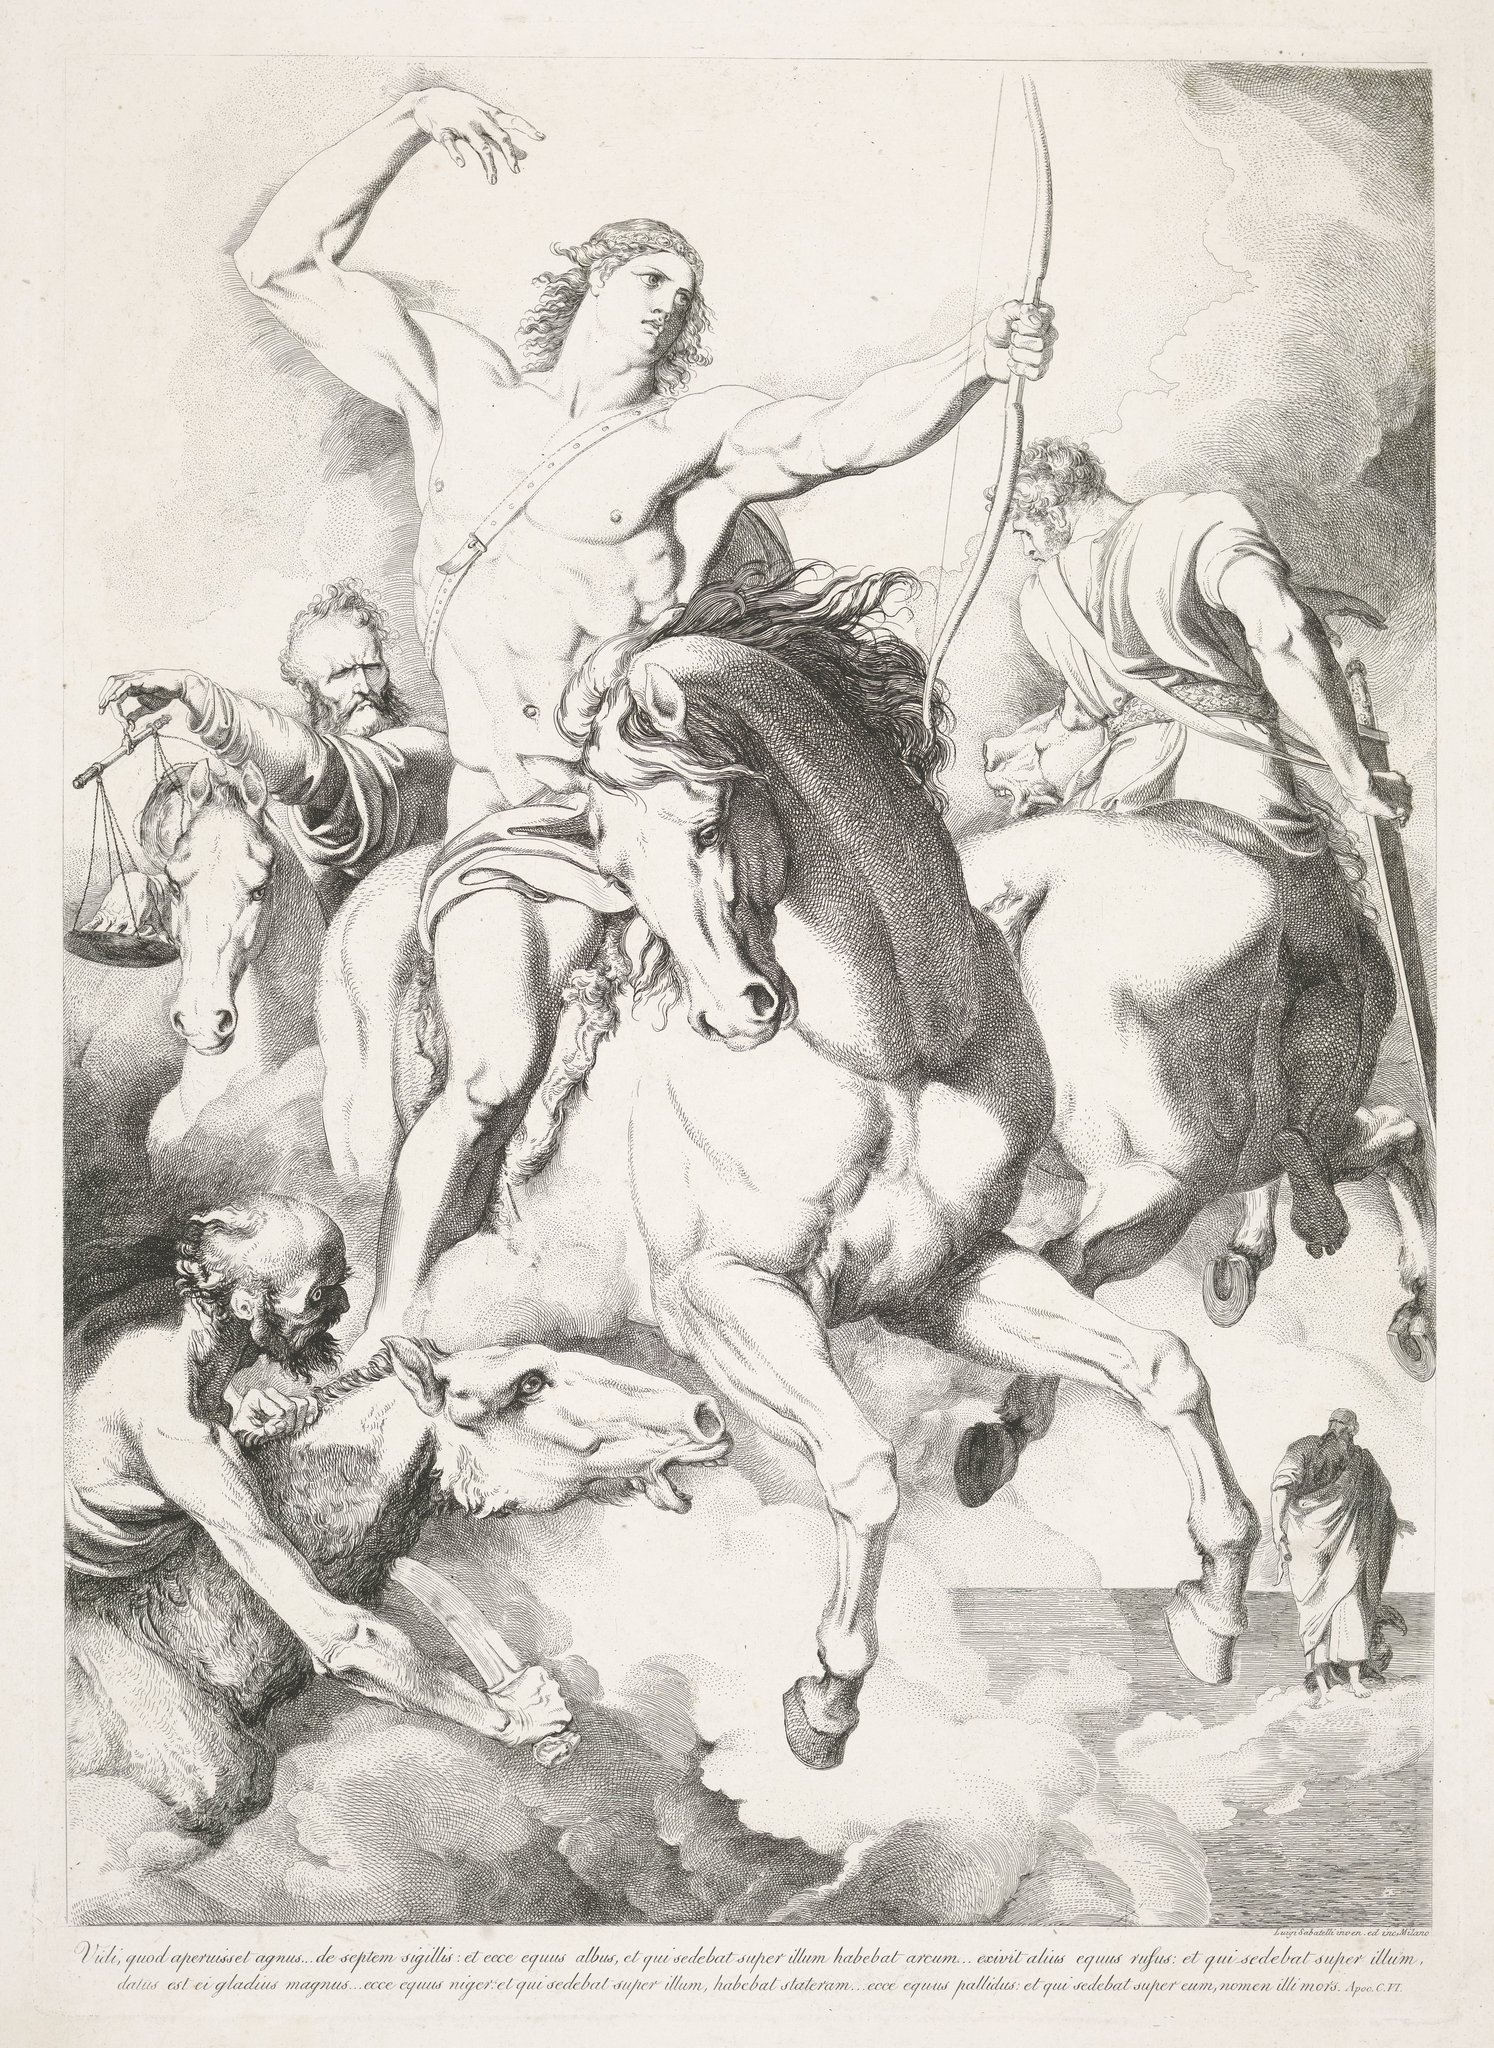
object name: print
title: De vier apocalyptische ruiters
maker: luigi sabatelli (i)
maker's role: print maker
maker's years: 1772-1850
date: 1782-1850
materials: paper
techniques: etching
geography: milan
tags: the four horsemen of the apocalypse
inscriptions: collector's mark: Lugt 2760, collector's mark: Lugt 2228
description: In het midden een apocalyptische ruiter met pijl-en-boog. Om hem heen een ruiter met balans, een met sabel en een met zwaard. Op de achtergrond rechts (op aarde) de apostel Johannes met zijn attribuut de adelaar, opkijkend naar de ruiters in de wolken.